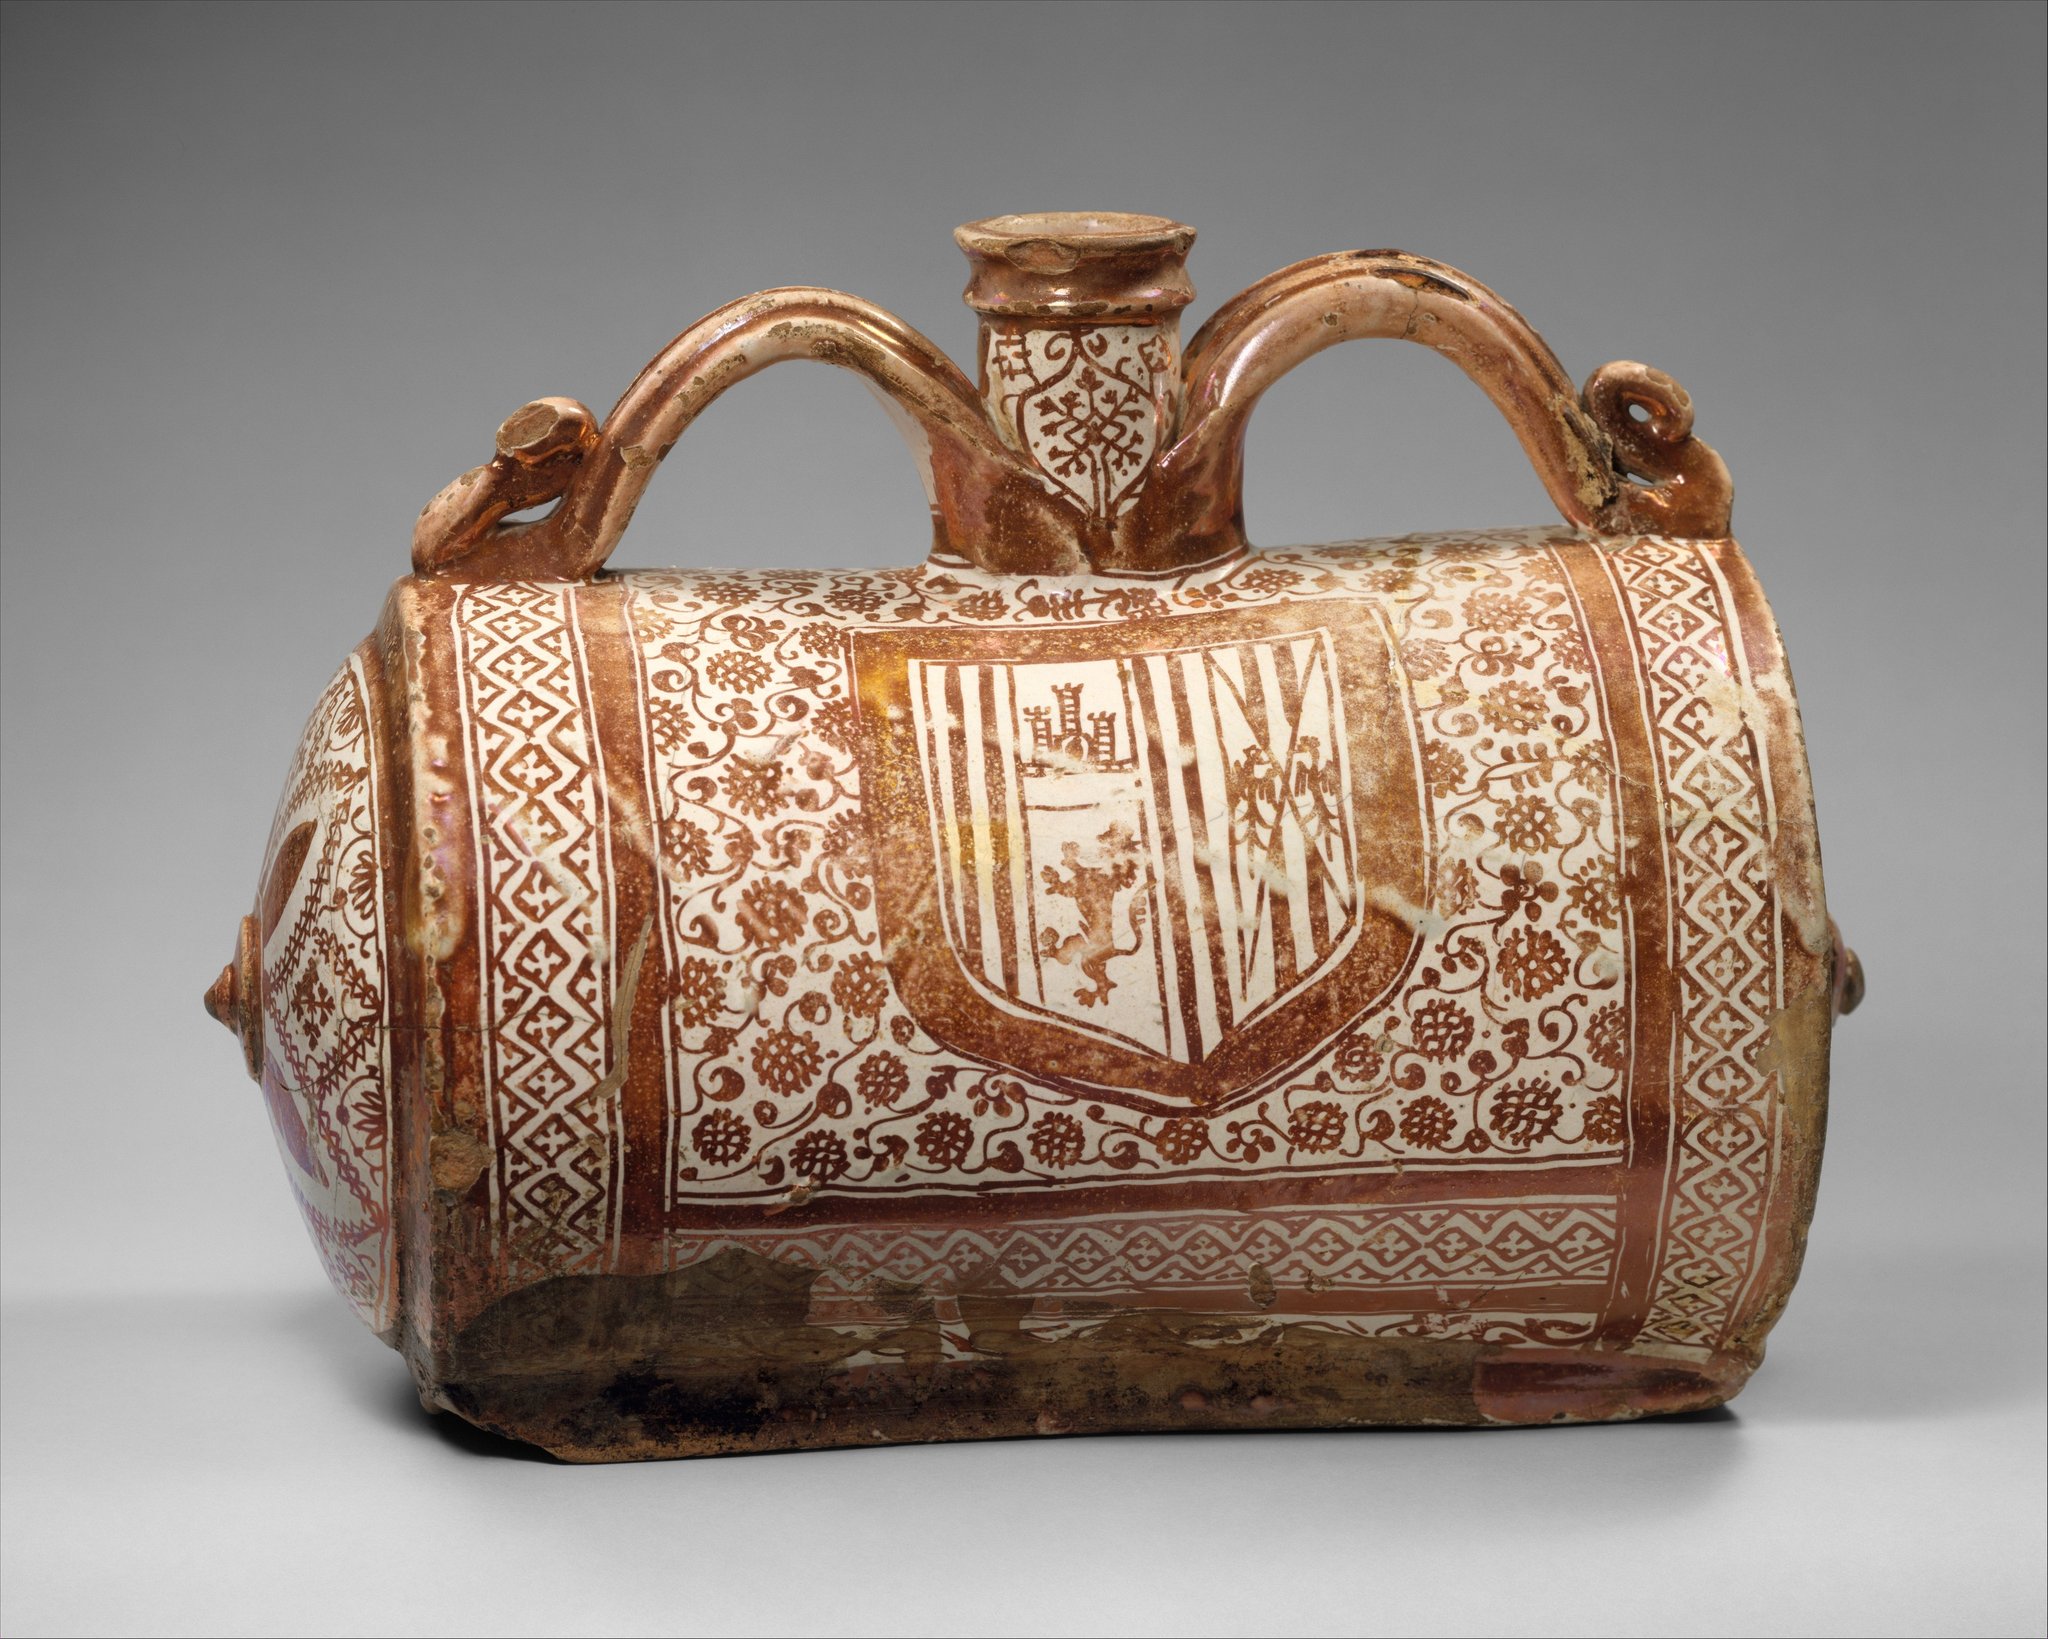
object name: bottle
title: Bottle (Refredador)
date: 1501-1550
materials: earthenware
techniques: luster painting, glazing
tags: coat of arms